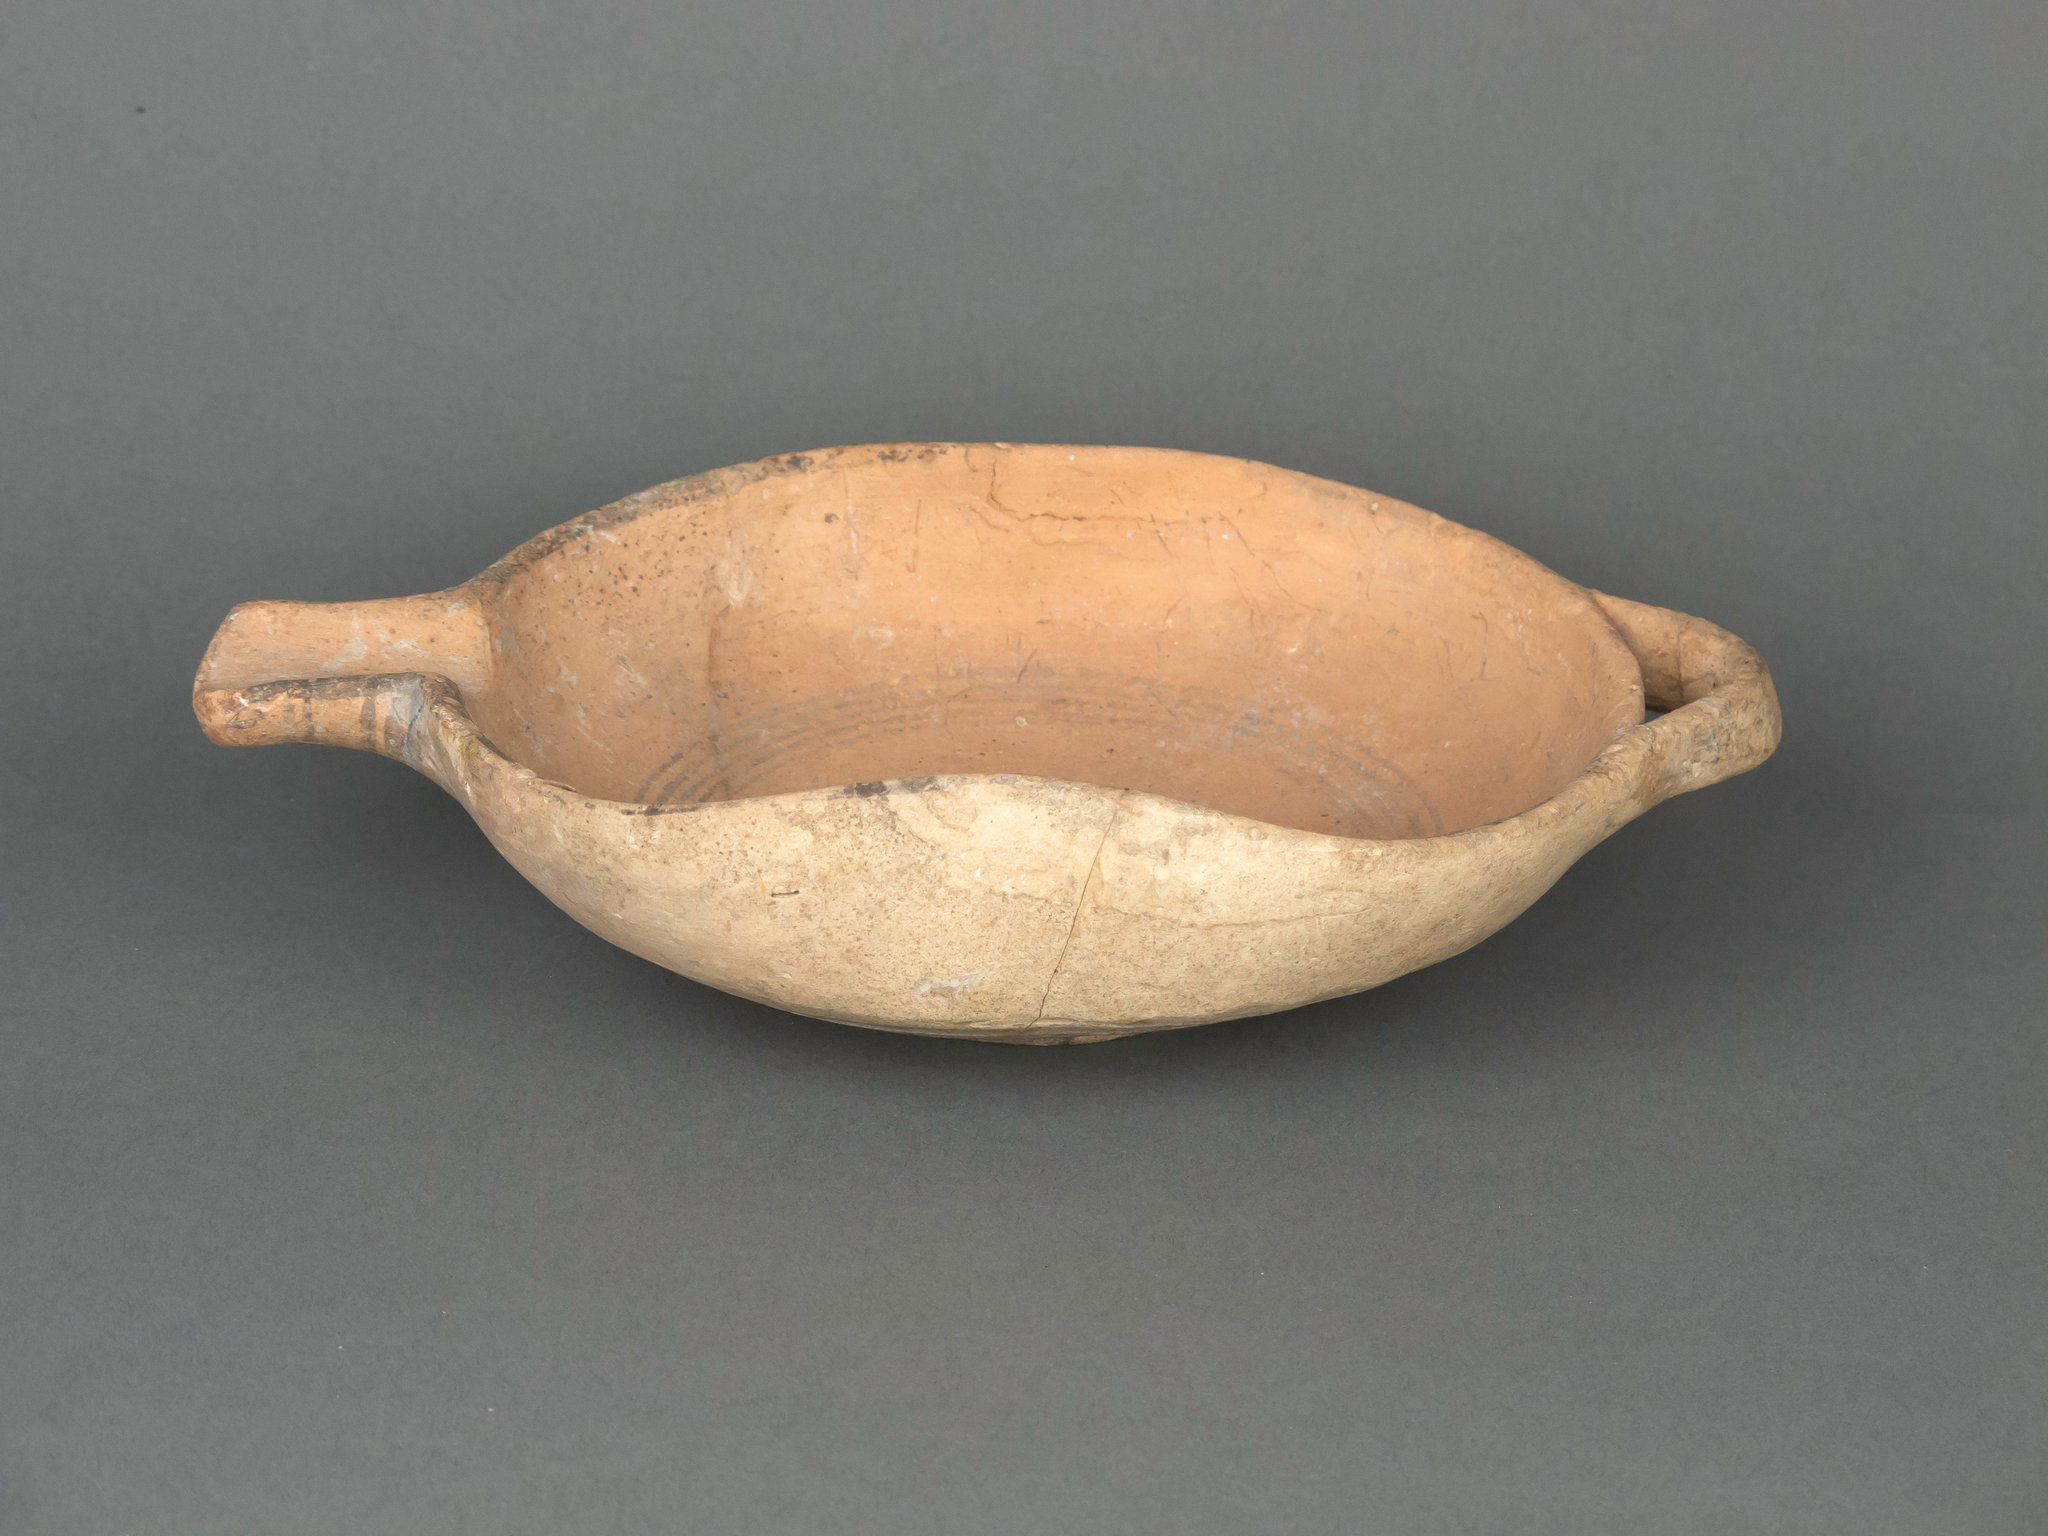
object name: plate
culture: cypriot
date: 1050-900 BCE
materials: terracotta